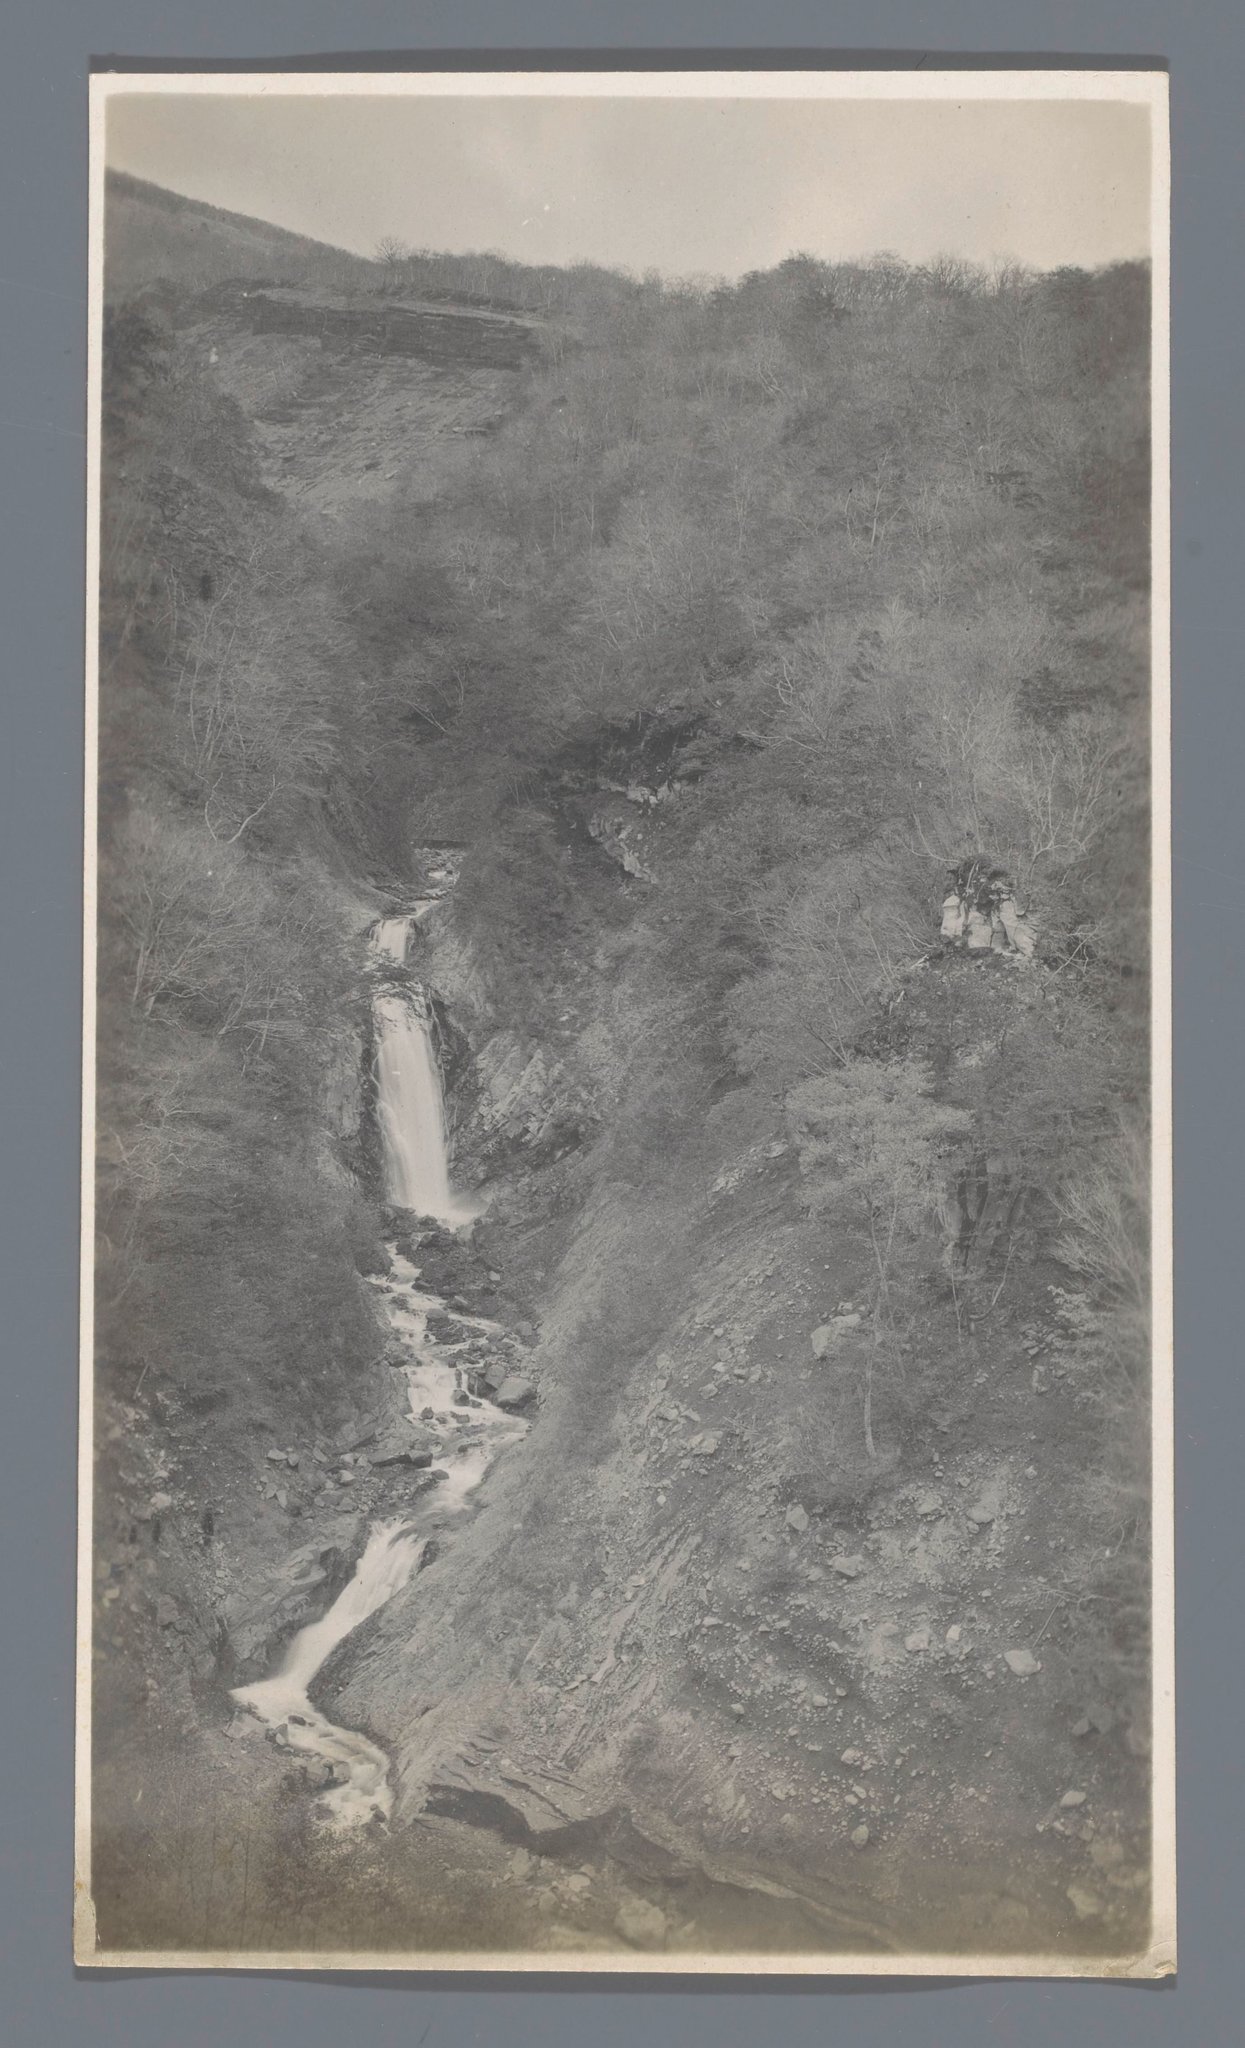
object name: photograph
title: Berglandschap met een waterval, Nikko (?), Japan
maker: jan adriani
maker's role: fotograaf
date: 1907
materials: paper, photographic support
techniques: gelatin silver print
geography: japan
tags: waterfall